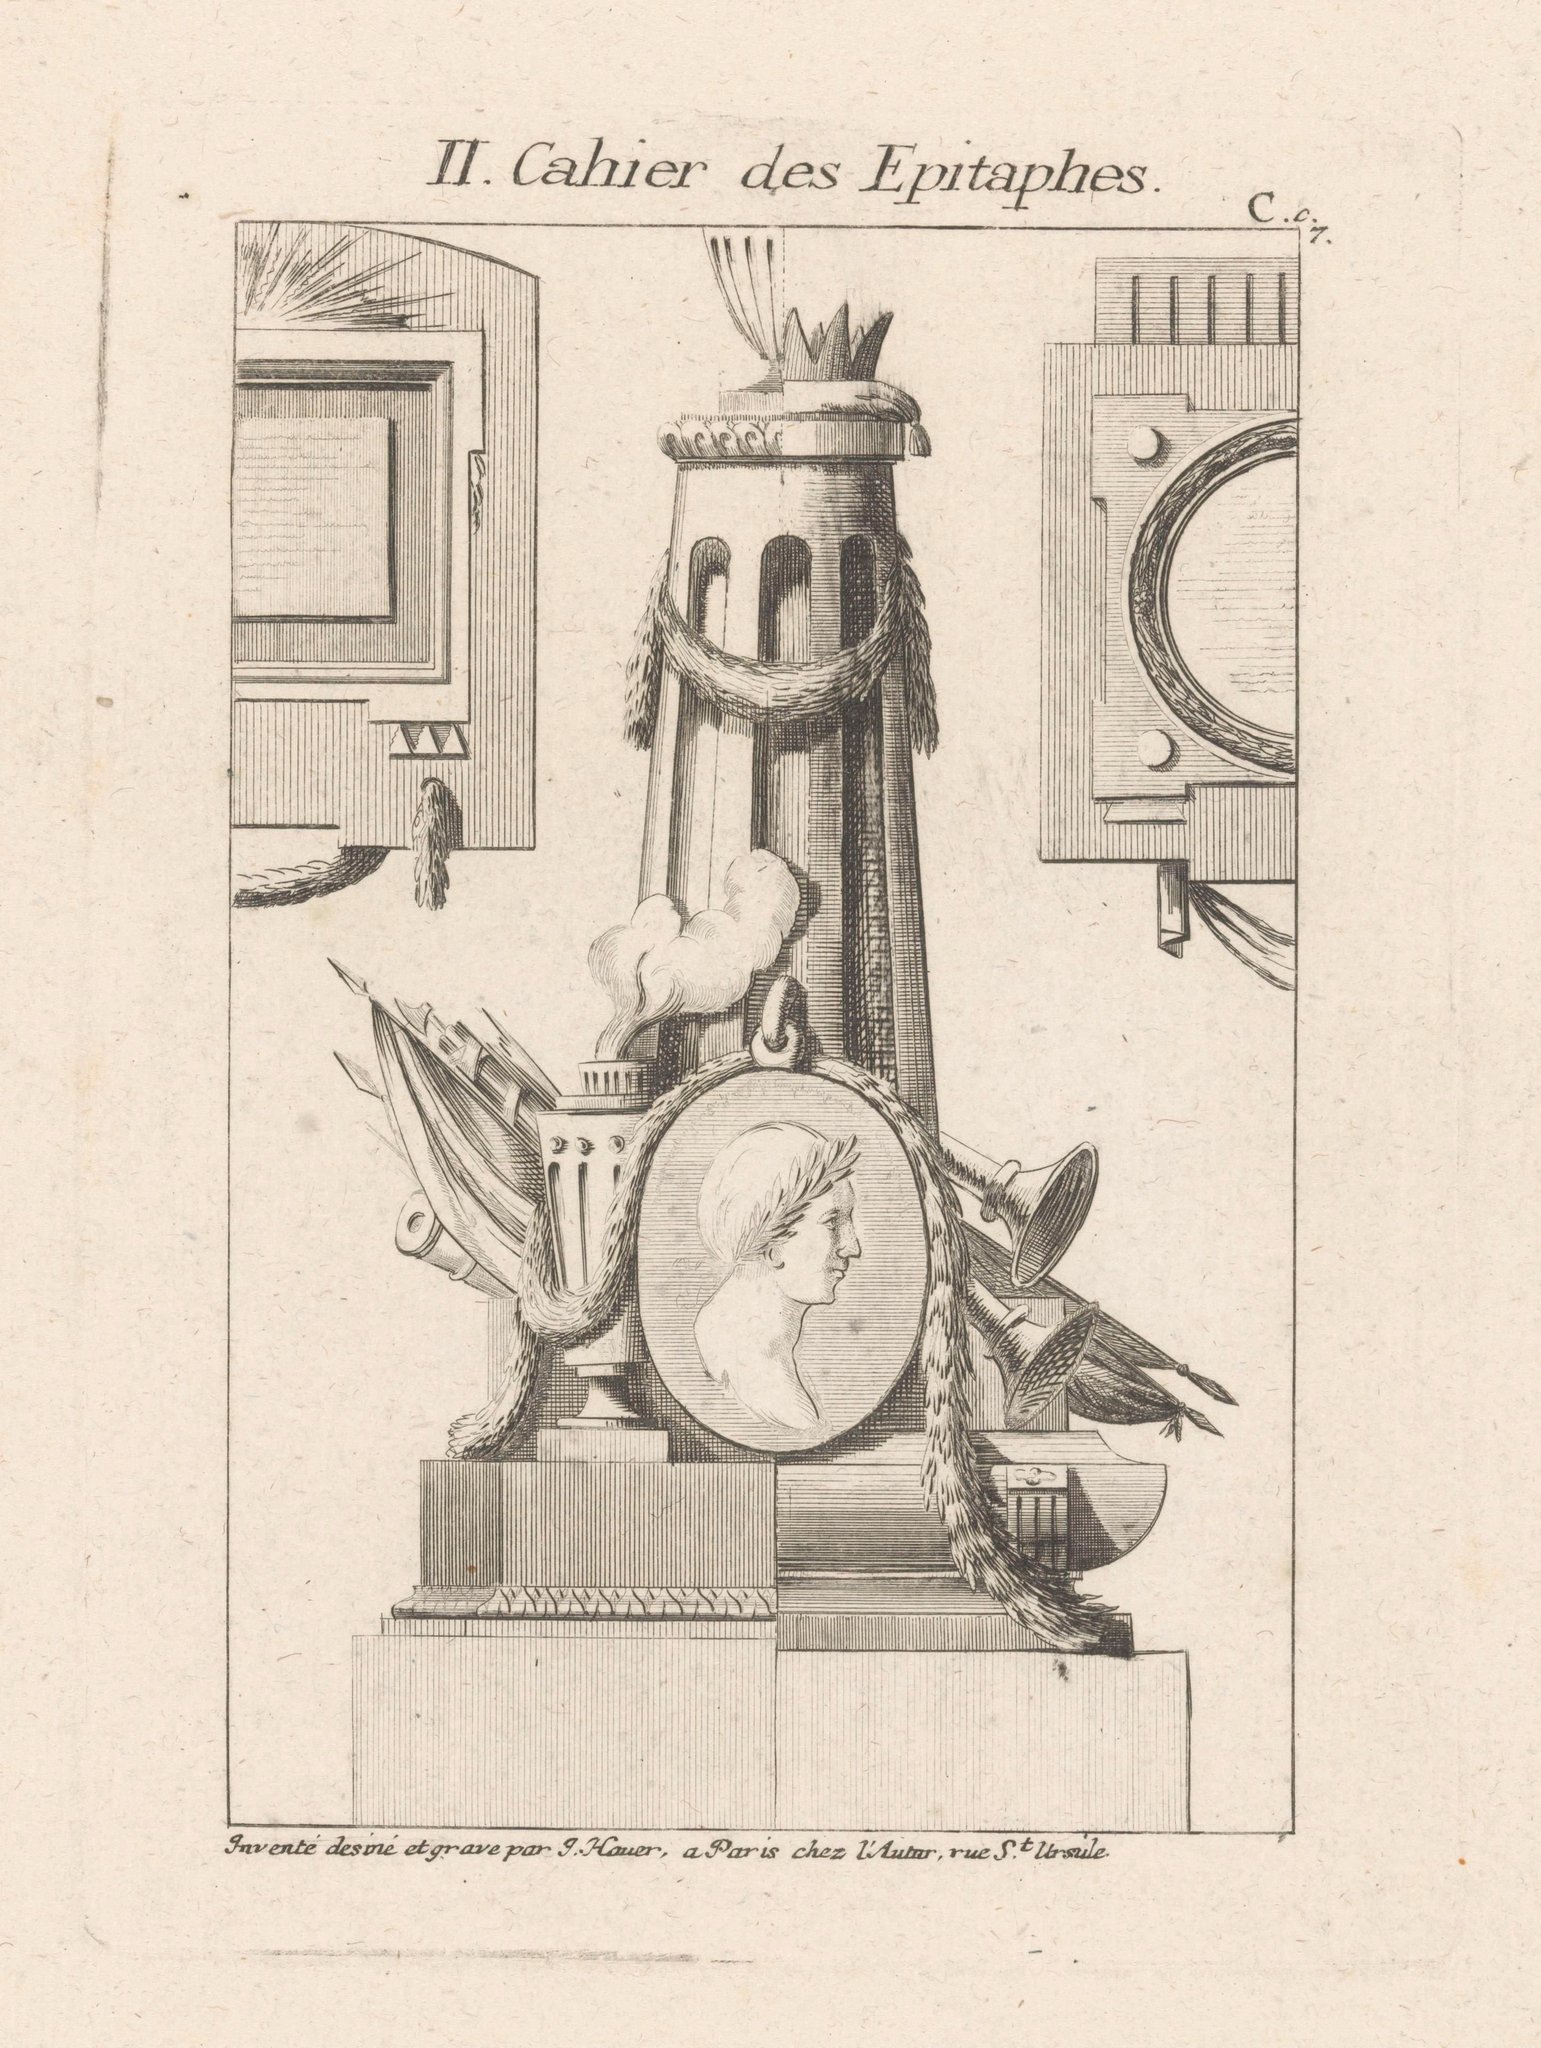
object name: print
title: Desseins de la Mode neuve au Gout antique (...)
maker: johann thomas hauer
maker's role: print maker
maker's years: 1748-1820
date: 1781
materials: paper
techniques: engraving, etching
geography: paris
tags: epitaph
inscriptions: collector's mark: Lugt 2228, collector's mark: Lugt 2760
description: Ontwerpen voor drie epitaven. Links en rechts vierkante epitaven met guirlandes, in het midden een epitaaf met ovaal medaillon met gezicht, een rookvat, bazuinen, wapens en een guirlande.